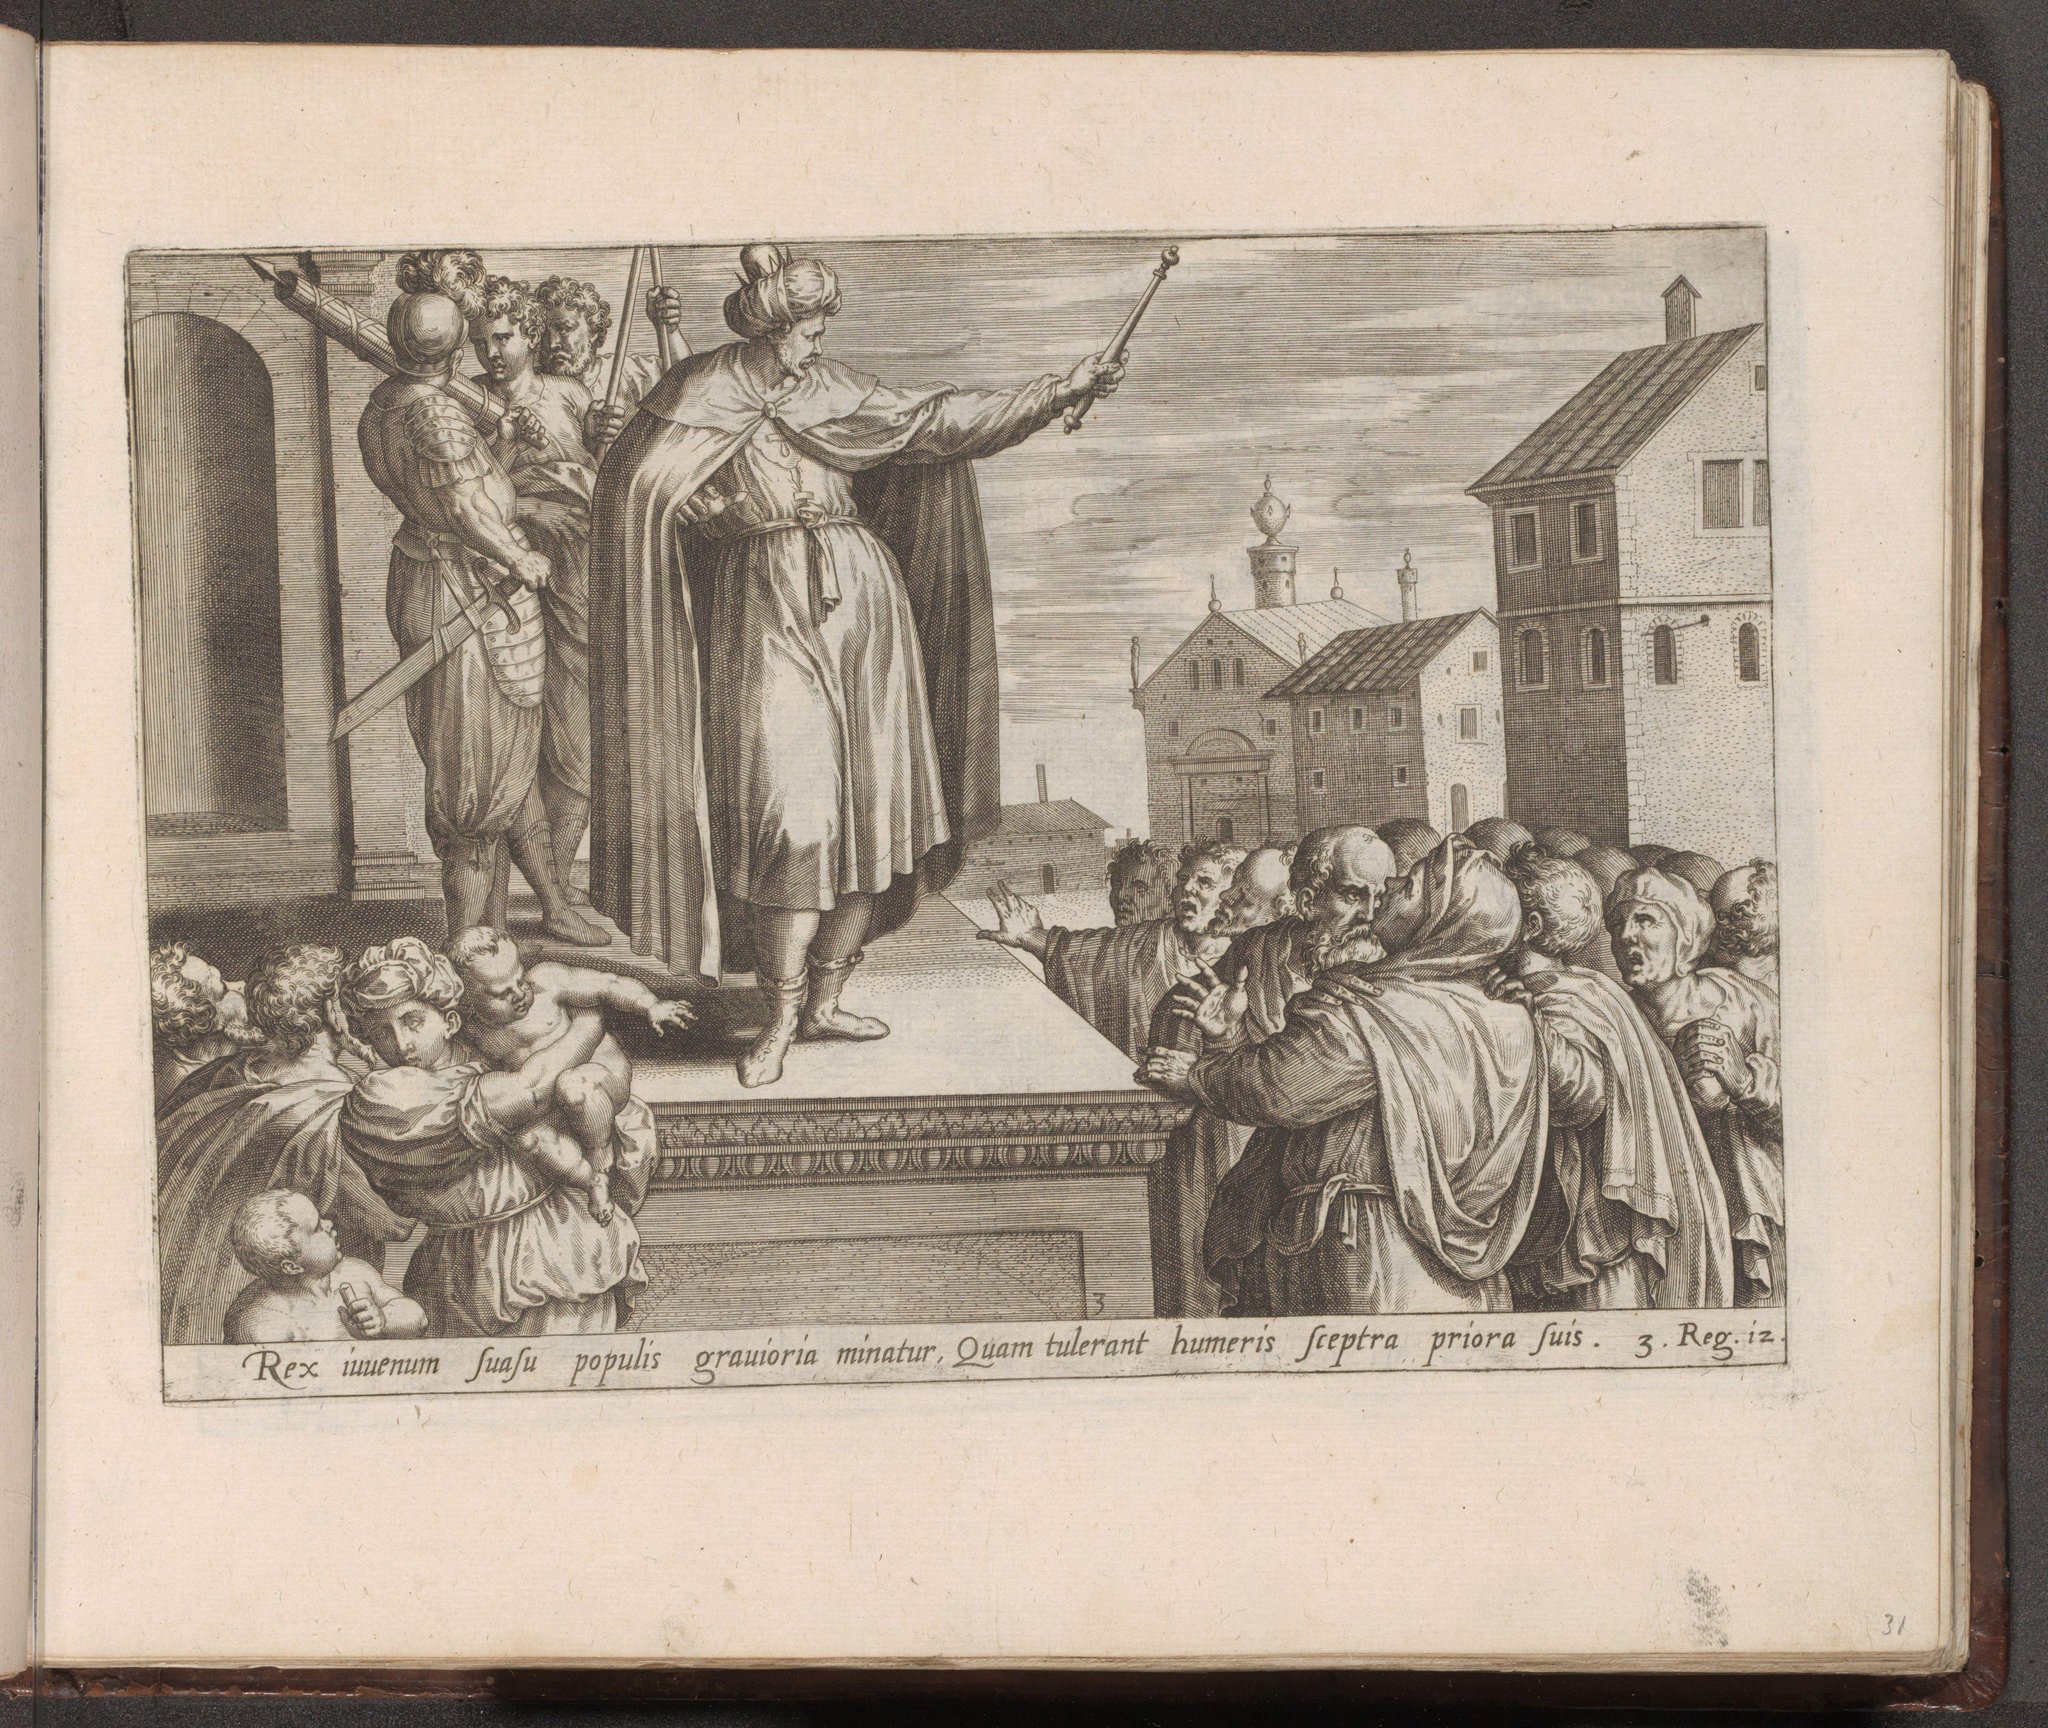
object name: album leaf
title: Thesaurus sacrarum historiaru[m] veteris testame[n]ti, elega[n]tissimis imaginibus expressu[m] excelle[n]tissimoru[m] in hac arte viroru[m] opera: nu[n]c primu[m] in luce[m] editus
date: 1579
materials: paper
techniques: engraving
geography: antwerp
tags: rehoboam's insulting reply: forsaking the warning of the wise old counsel- lors but following the young advisers' opinion, rehoboam not only refuses to lessen the taxes, but increases them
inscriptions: caption: ‘Rex iuvenum suasu populis...priora suis. 3. Reg. 12.’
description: Koning Rechabeam geeft het volk Israël antwoord op hun verzoek tot verlichting van hun juk. Hij staat op een podium en deelt de mensen mee dat hij hun juk nog zal verzwaren. De mensen reageren verschrikt. De Israëlieten breken met Rechabeam, die alleen koning blijft over de steden van Juda. Onder de voorstelling een verwijzing in het Latijn naar de Bijbeltekst in 1 Kon. 12. Prent maakt deel uit van een album.